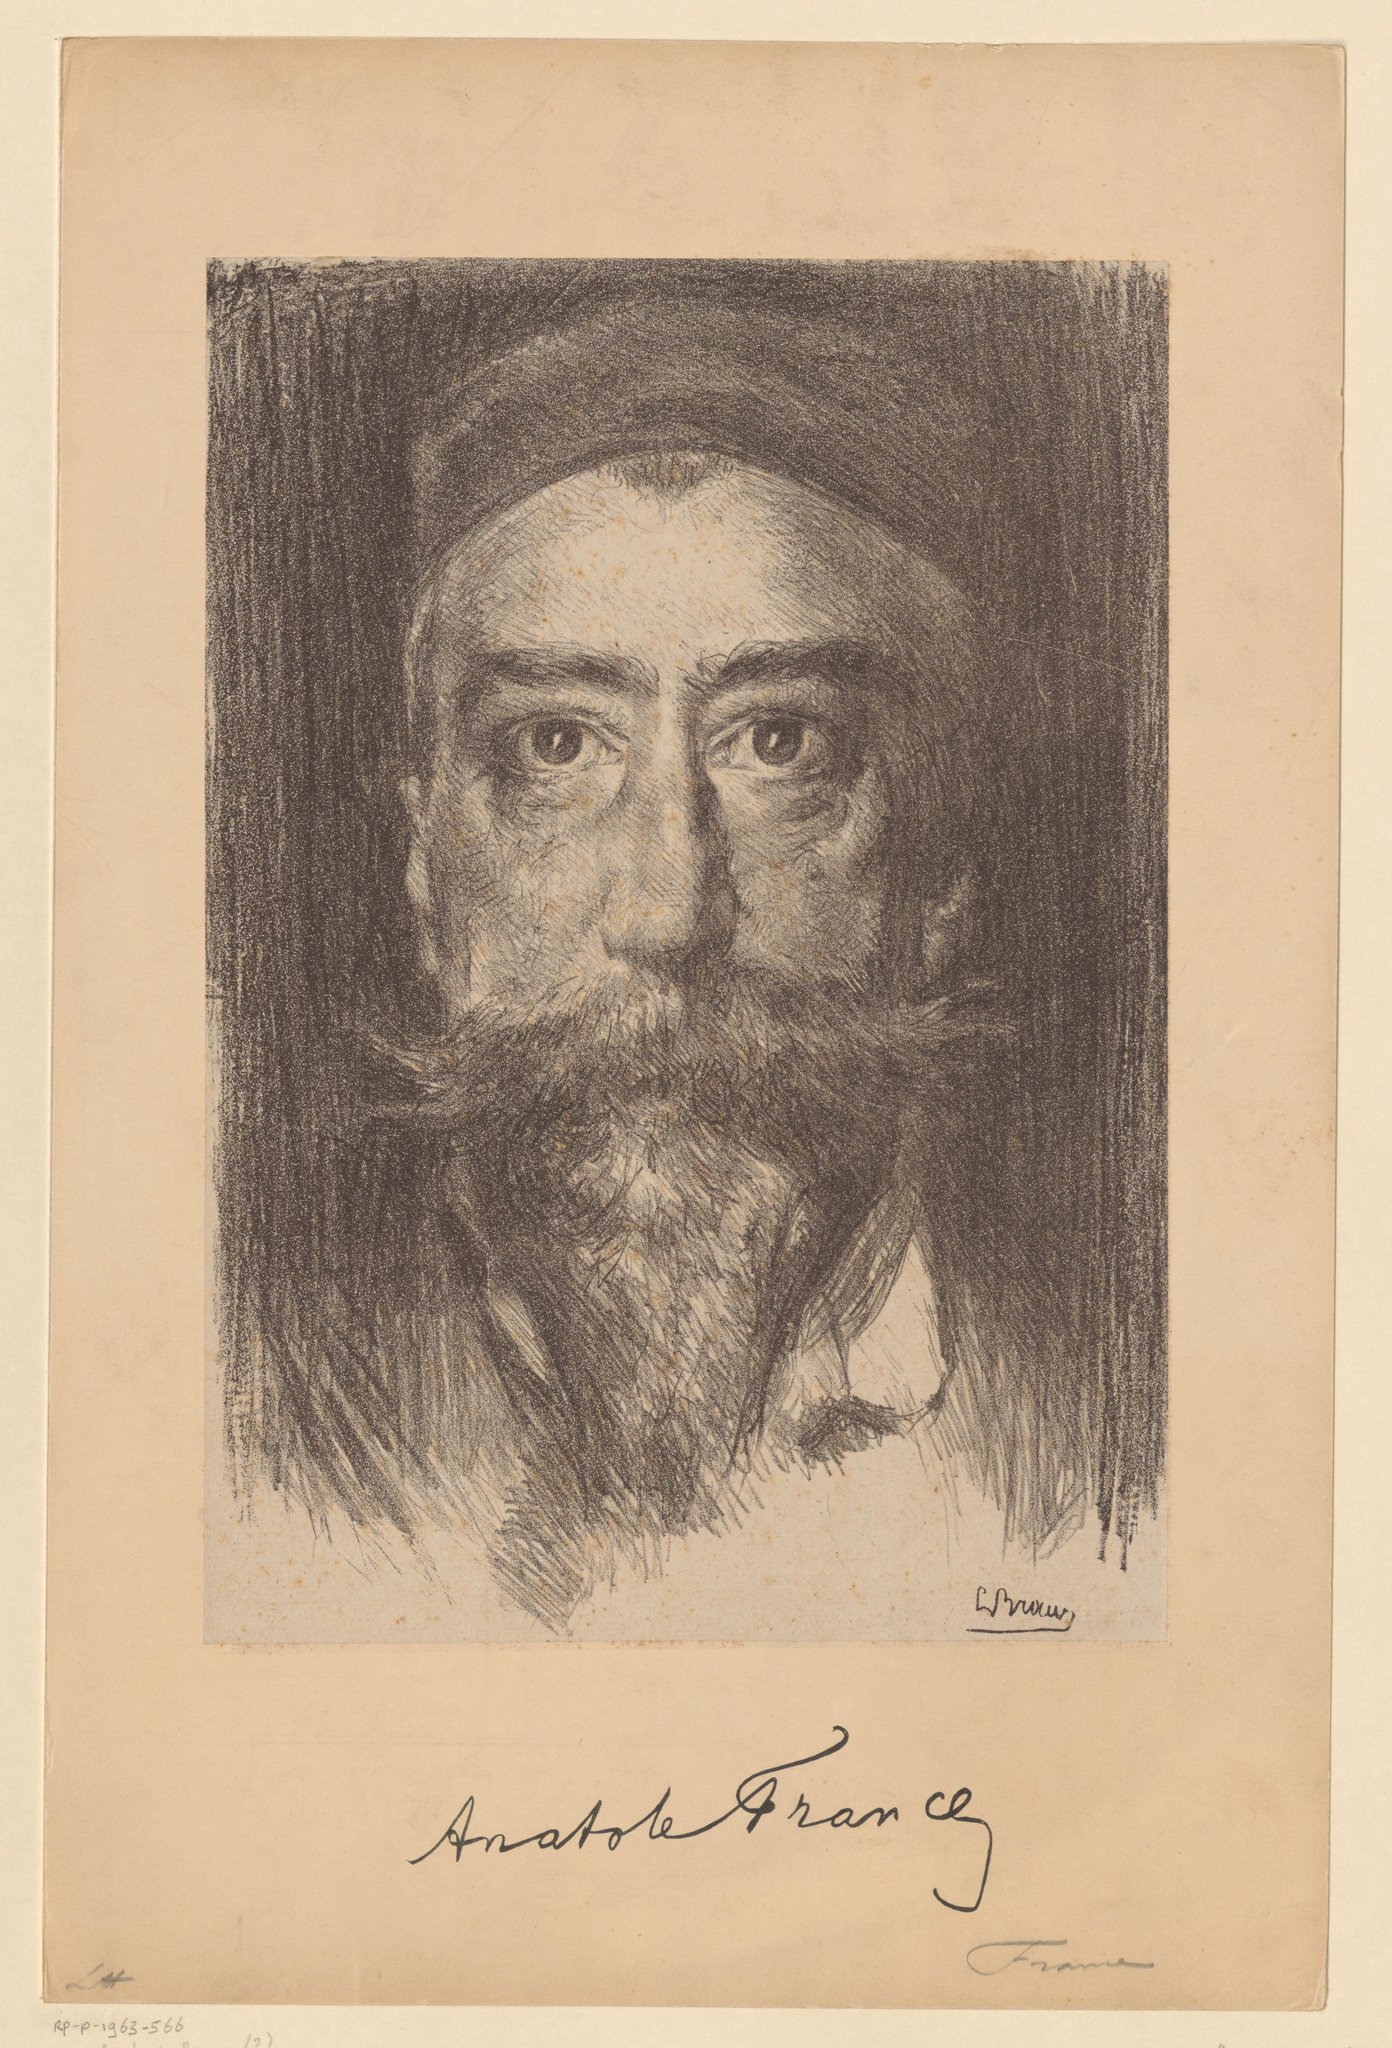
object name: print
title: Portret van Anatole France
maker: Anonymous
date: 1884-1930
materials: cardboard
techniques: lithograph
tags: historical persons, portrait of a writer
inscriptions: signature: ‘[LBrown?]’, collector's mark: Lugt 2228